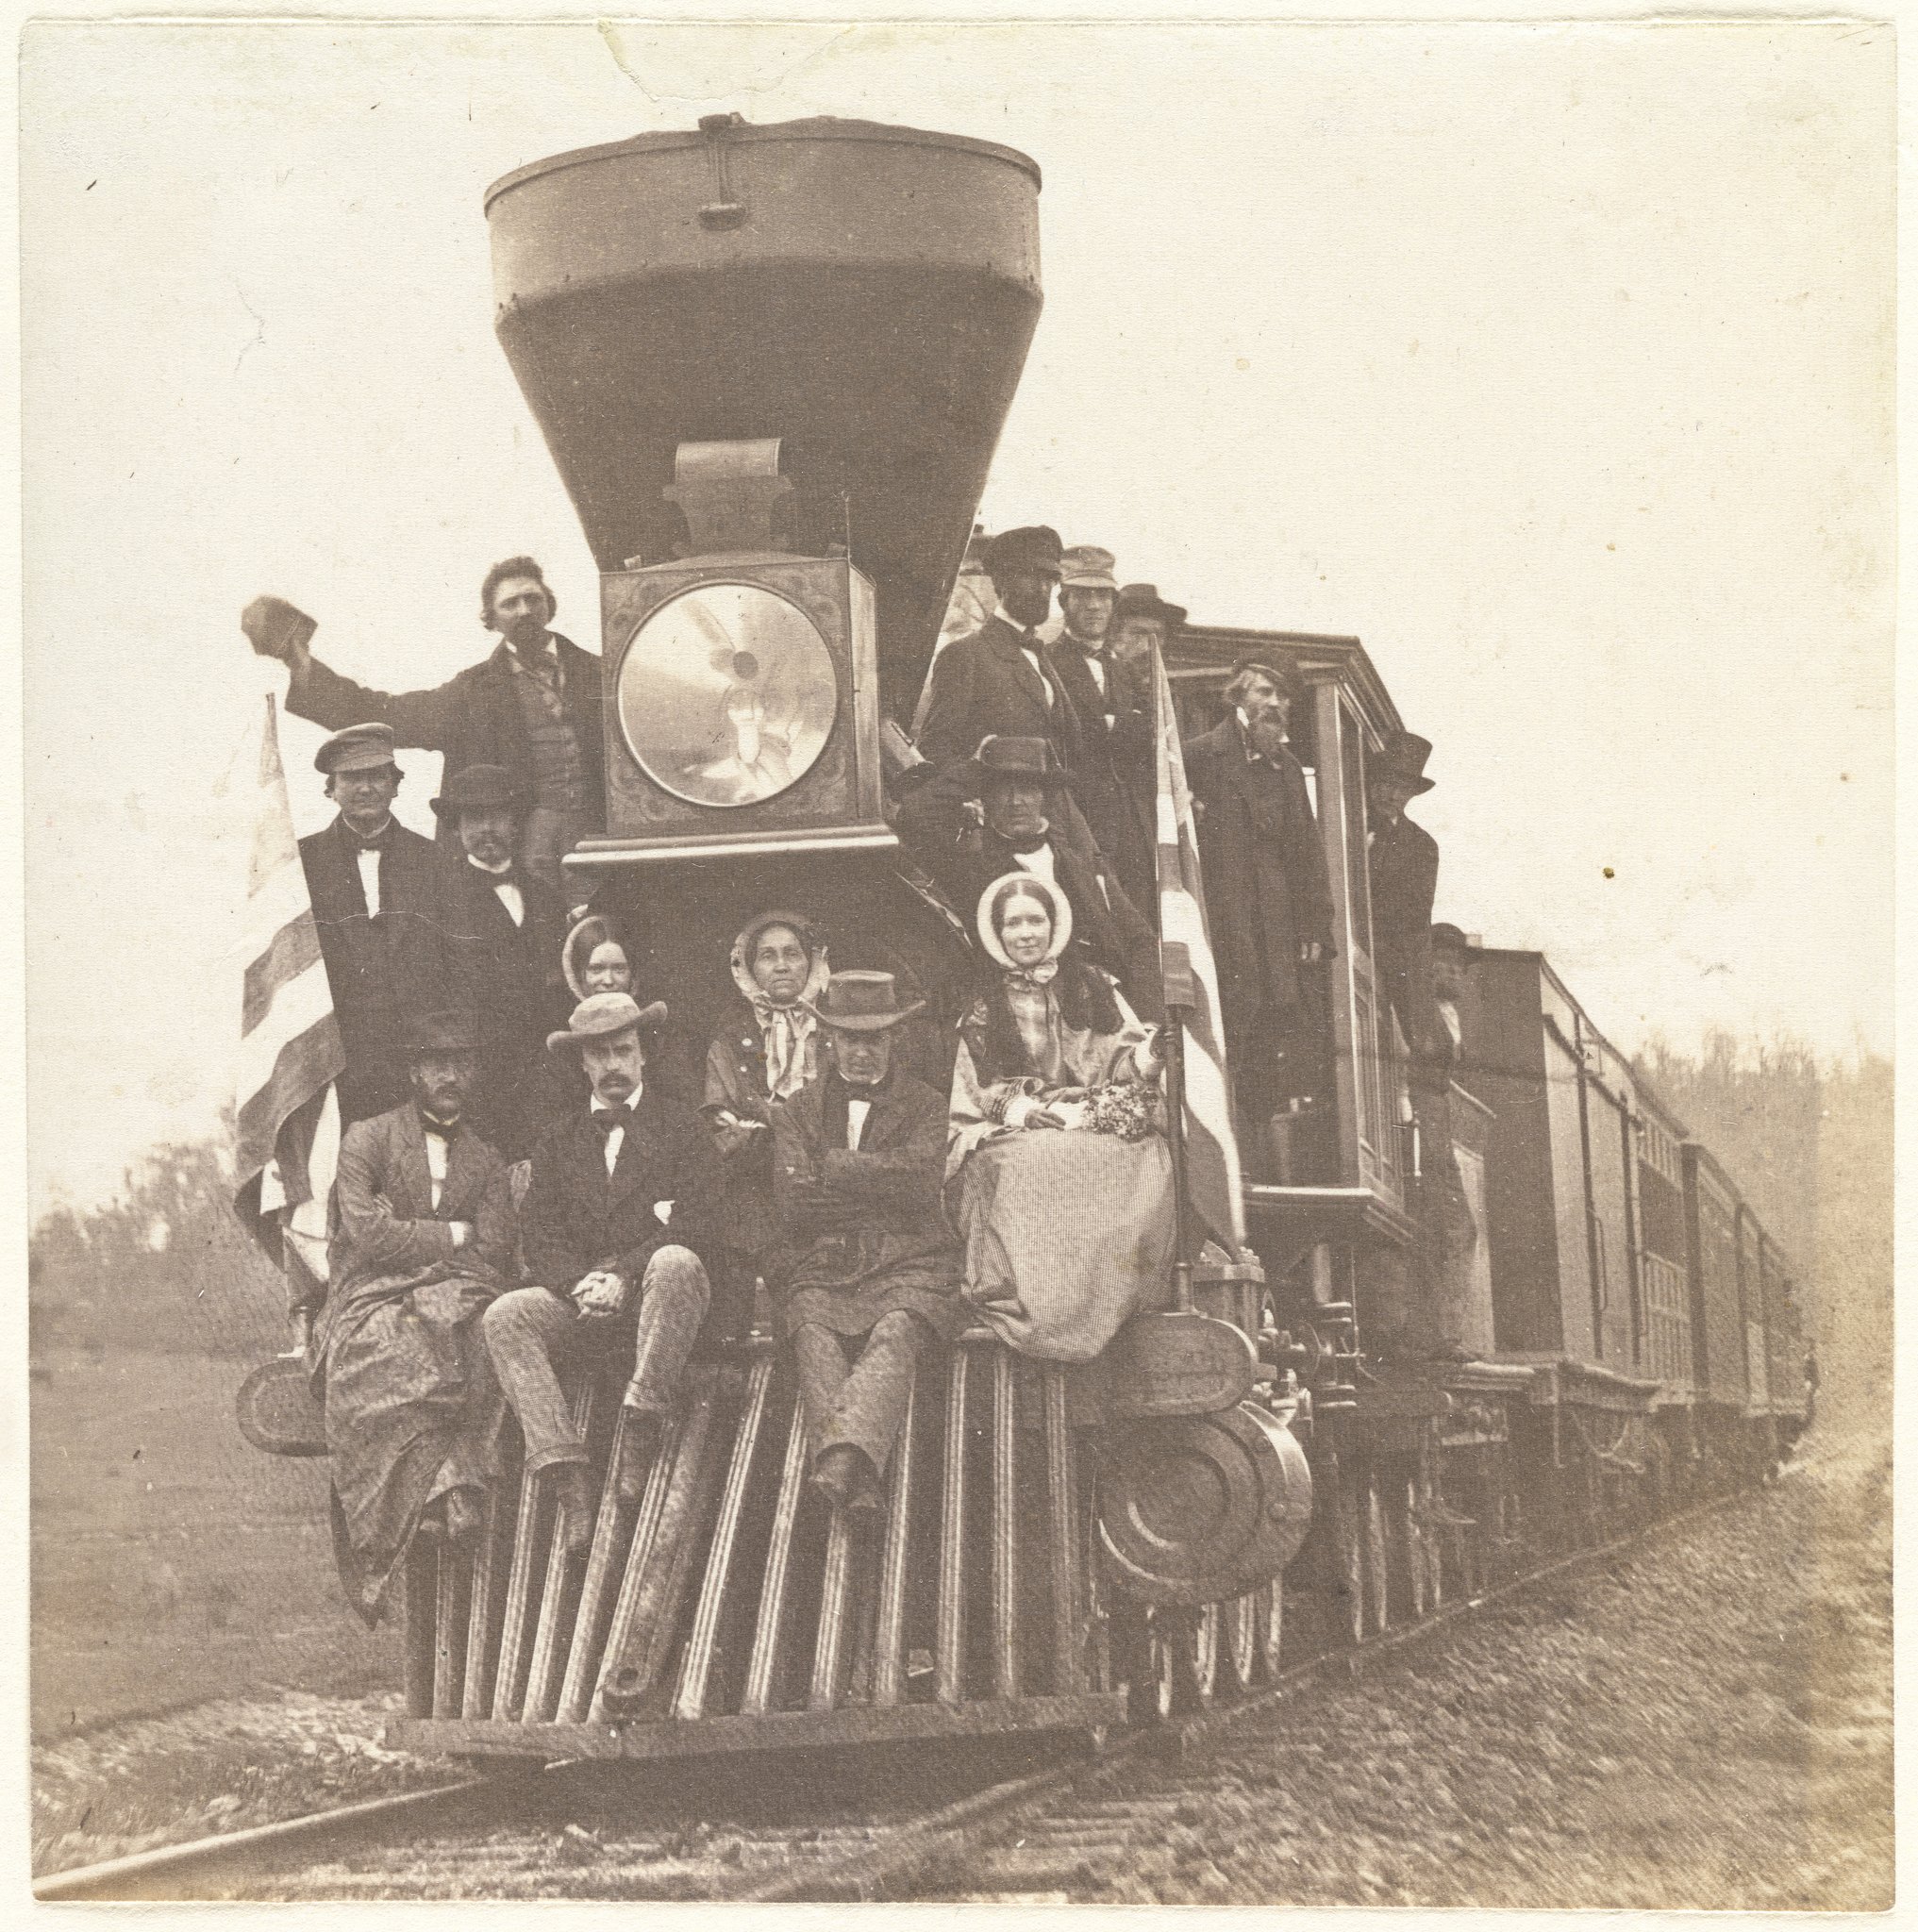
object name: photograph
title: [Artists' Excursion on the Baltimore & Ohio Railroad]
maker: Anonymous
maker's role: artist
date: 1858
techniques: glass negative, salted paper print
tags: railways,men,women,trains